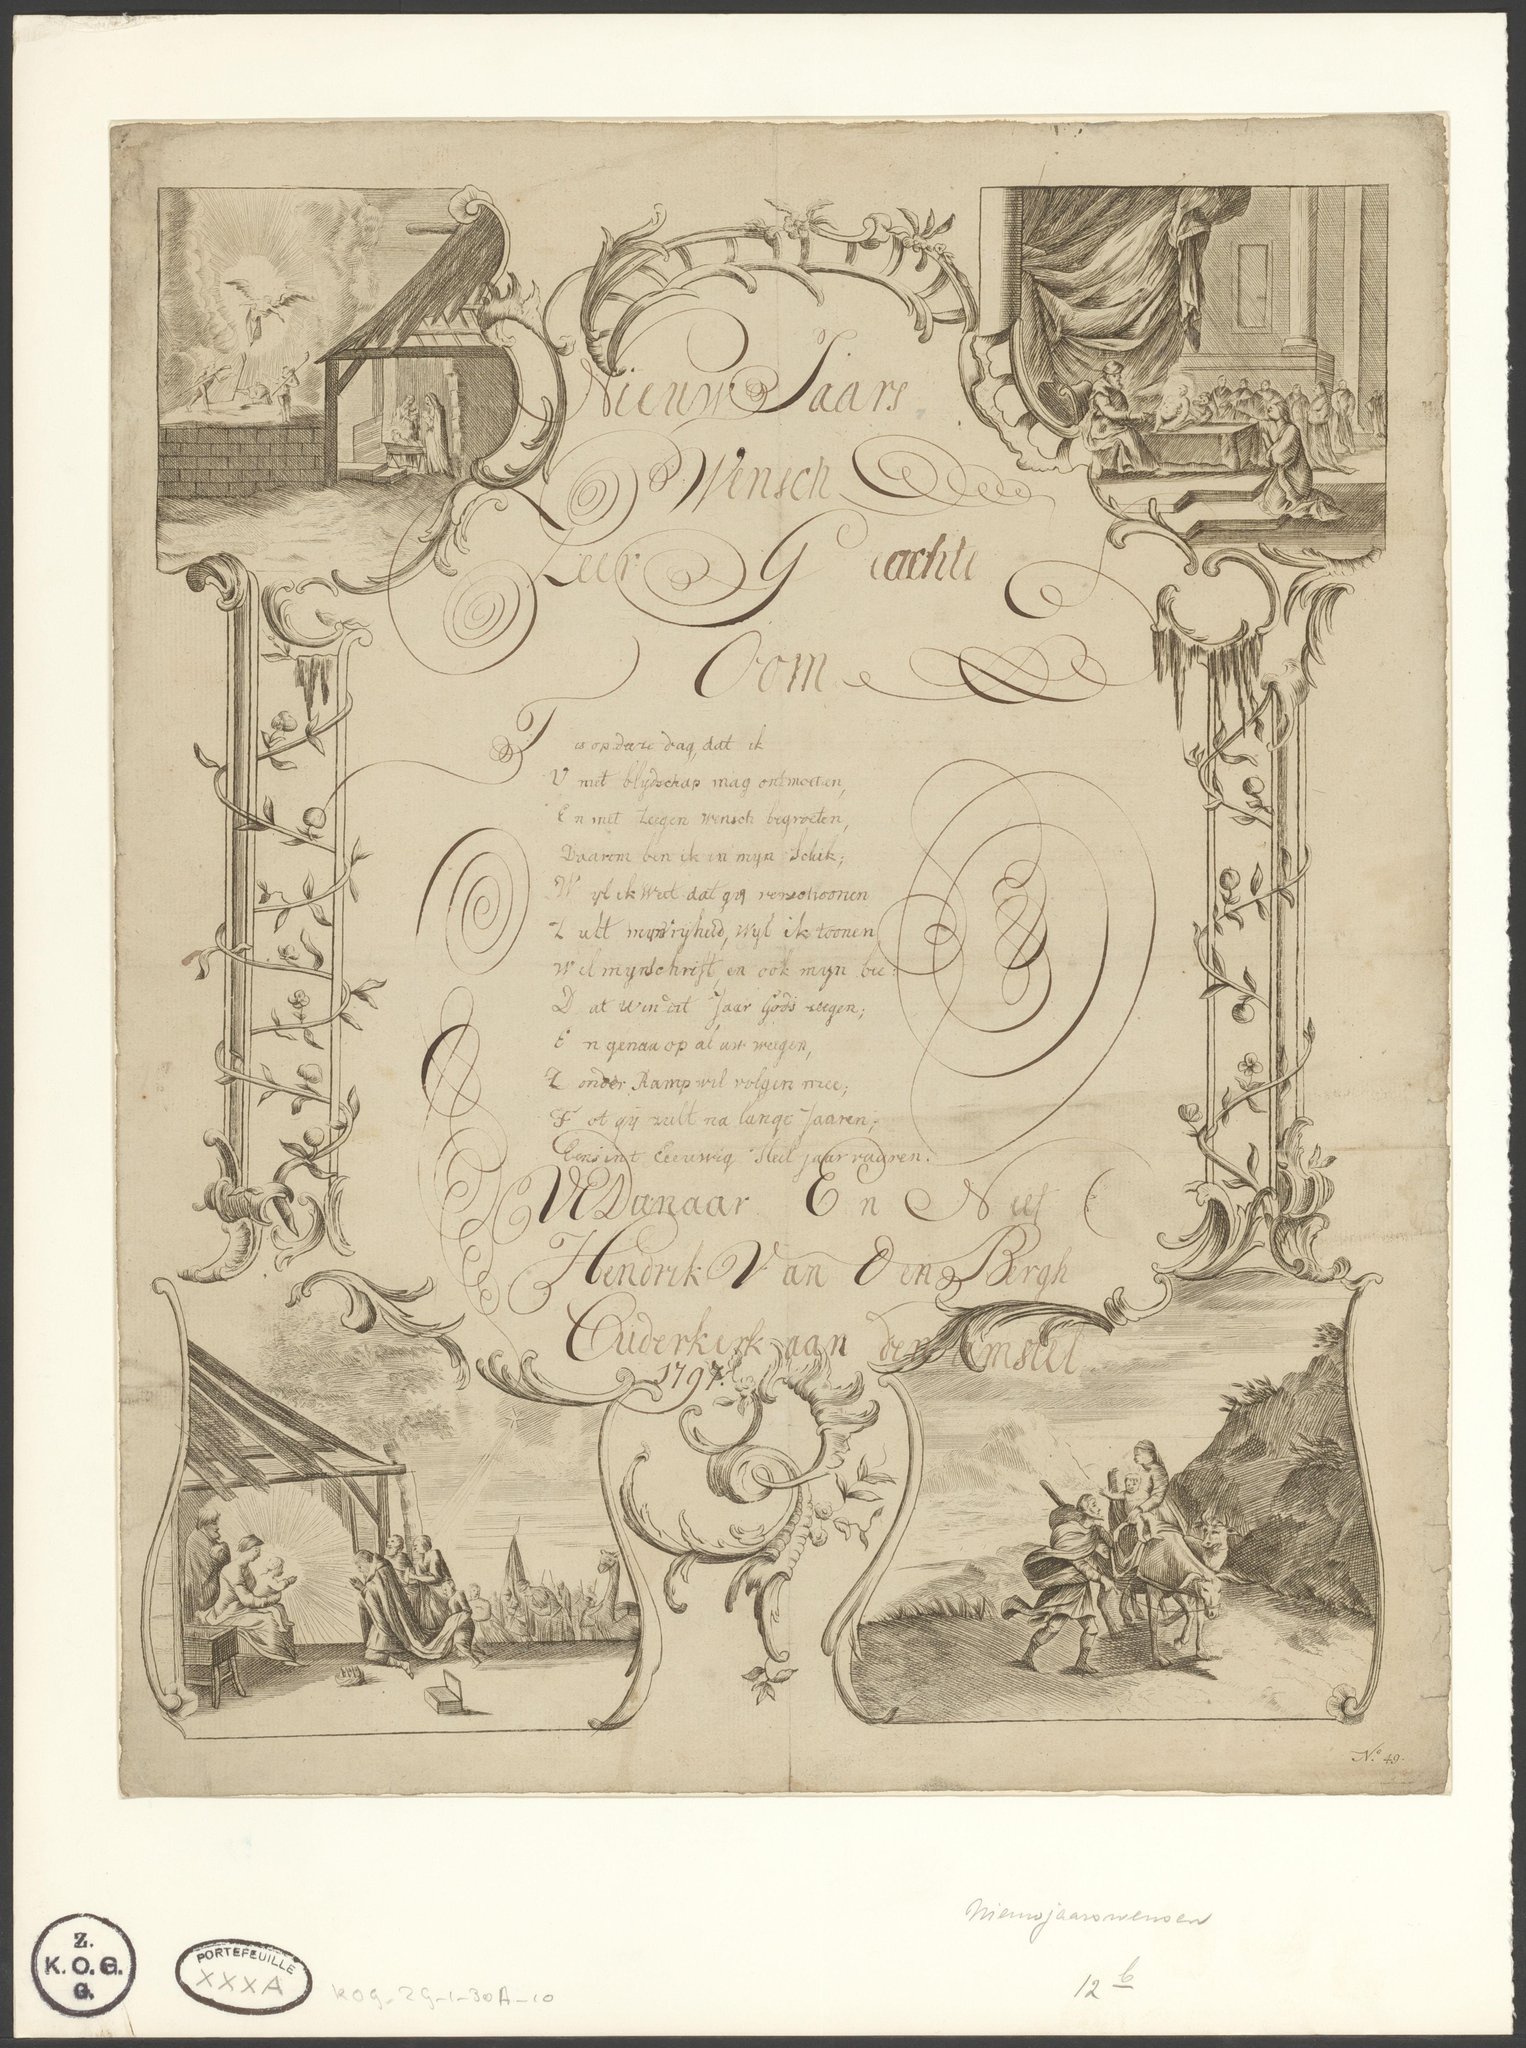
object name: wensbrief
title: Nieuwjaarswens van Hendrik van den Bergh, 1797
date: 1797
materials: ink, paper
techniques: engraving, etching, writing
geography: netherlands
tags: january 1 (~ festivities), birth and youth of christ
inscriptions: collector's mark: Lugt 1641, collector's mark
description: Nieuwjaarswens van Hendrik van den Bergh, 1797. Gericht aan zijn oom. Handgeschreven vers binnen een voorgedrukte omlijsting met ornamenten en voorstellingen van de geboorte van Christus. Rechtsonder genummerd: No. 49. Onderwerpsrubrieken binnen de Atlas Zeden en Gewoonten: Nieuwjaars- en kermiswenschen.